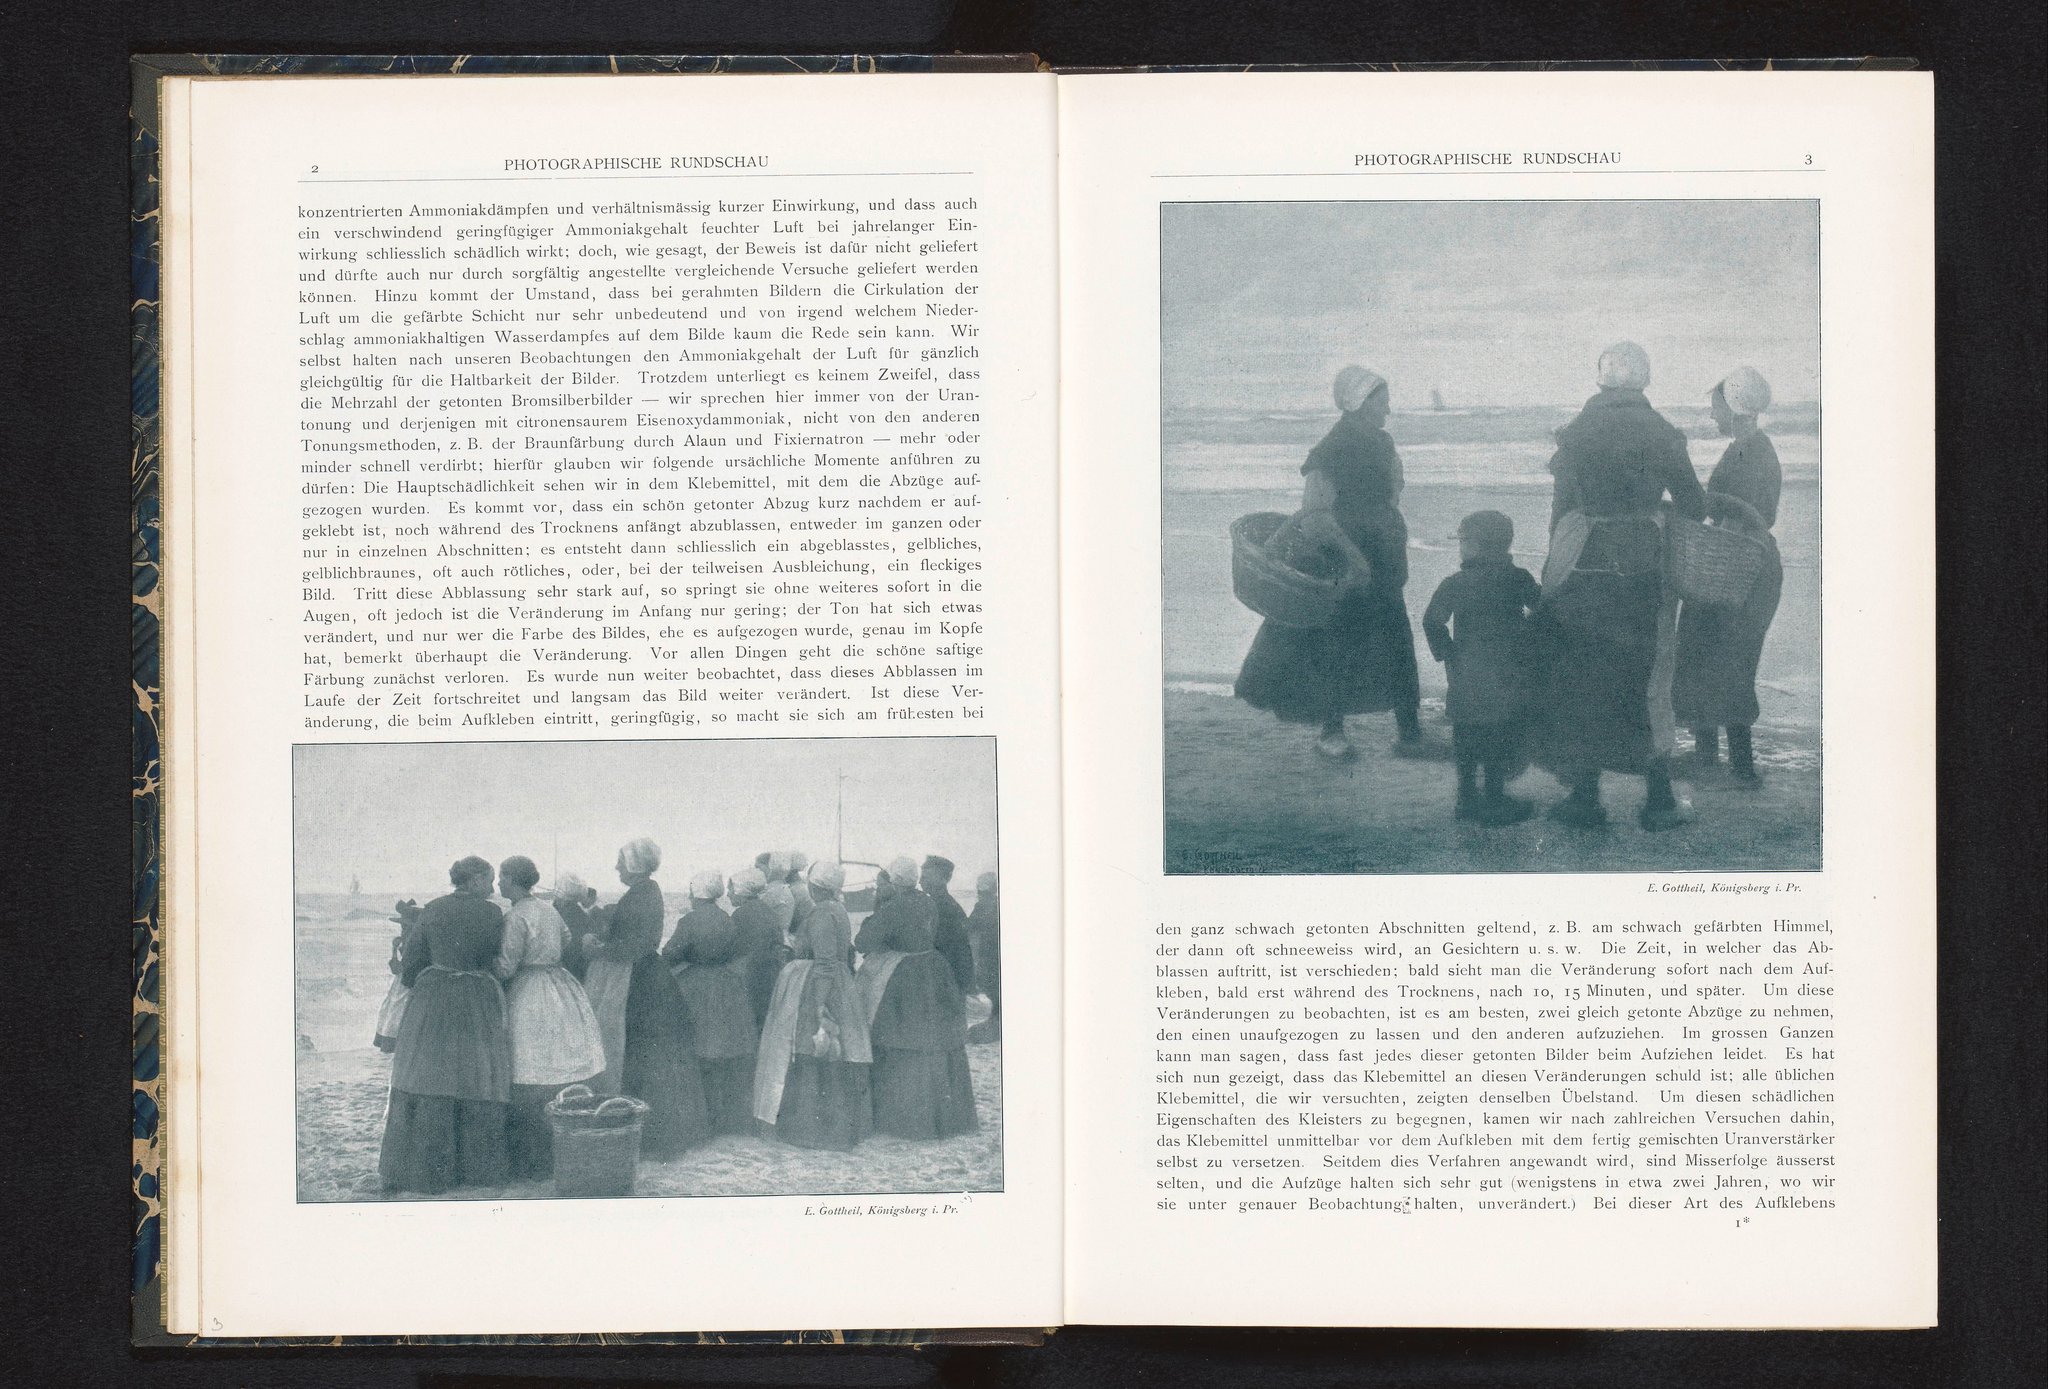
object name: photomechanical print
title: Groep vrouwen kijkt uit over de zee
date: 1896-1901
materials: paper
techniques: autotype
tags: adult woman, coast